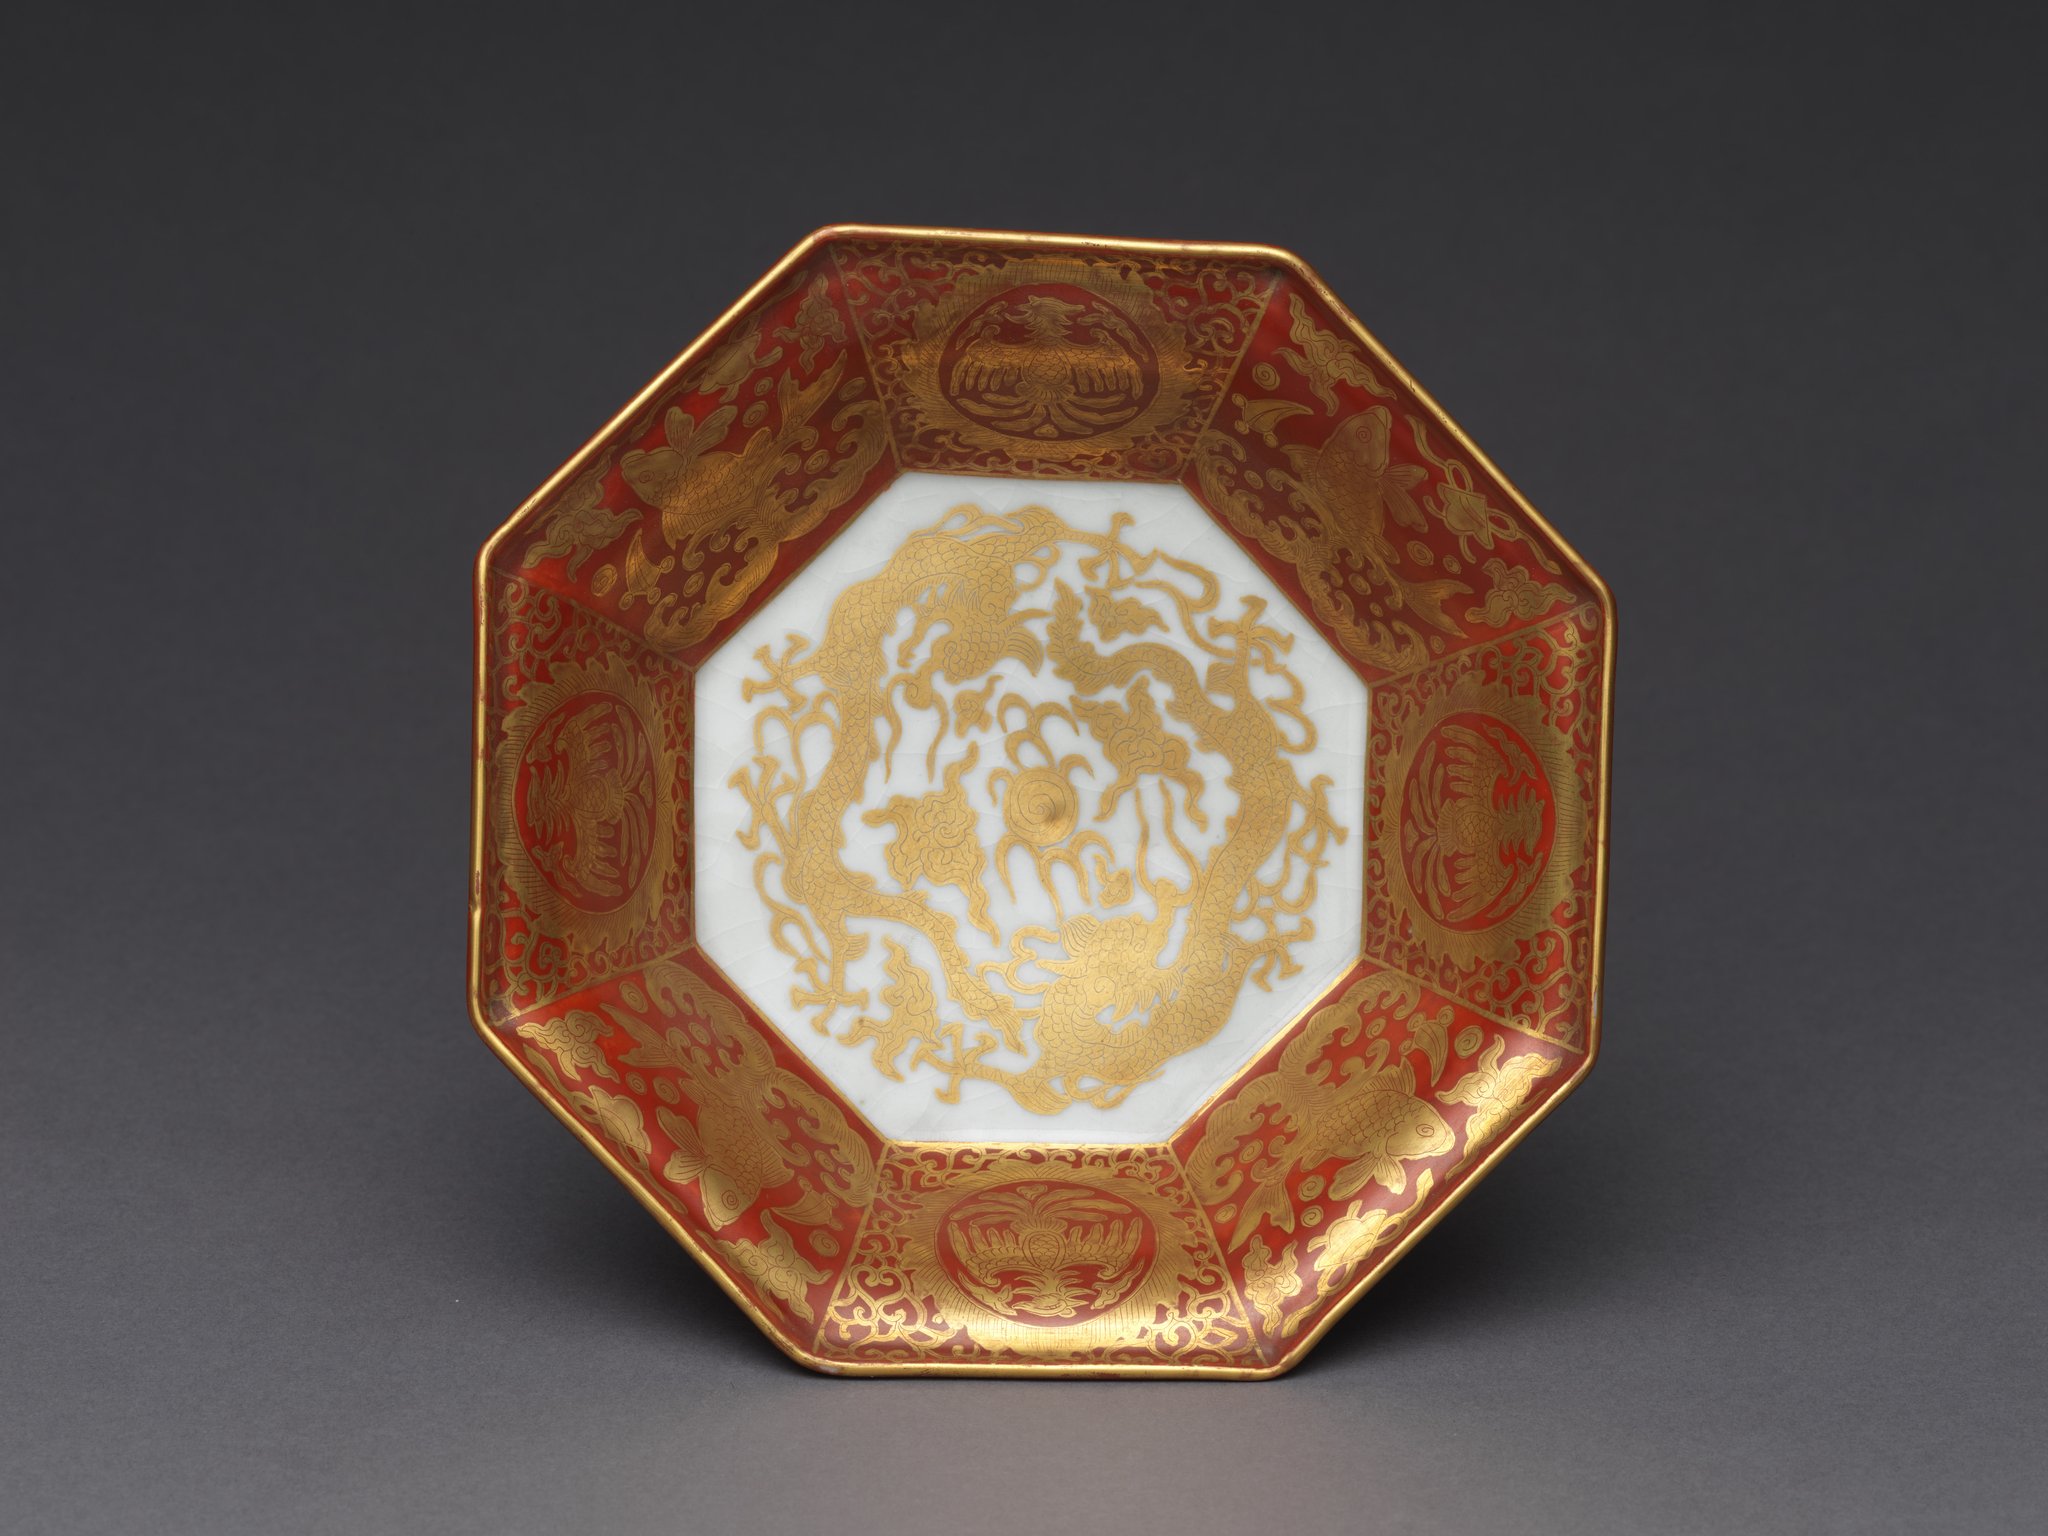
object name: bowl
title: Octagonal Bowl with Dragons and Auspicious Motifs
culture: japanese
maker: eiraku tokuzen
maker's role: artist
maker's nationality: japanese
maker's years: 1853-1909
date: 1851-1900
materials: glaze, gold, porcelain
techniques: painting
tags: dragons